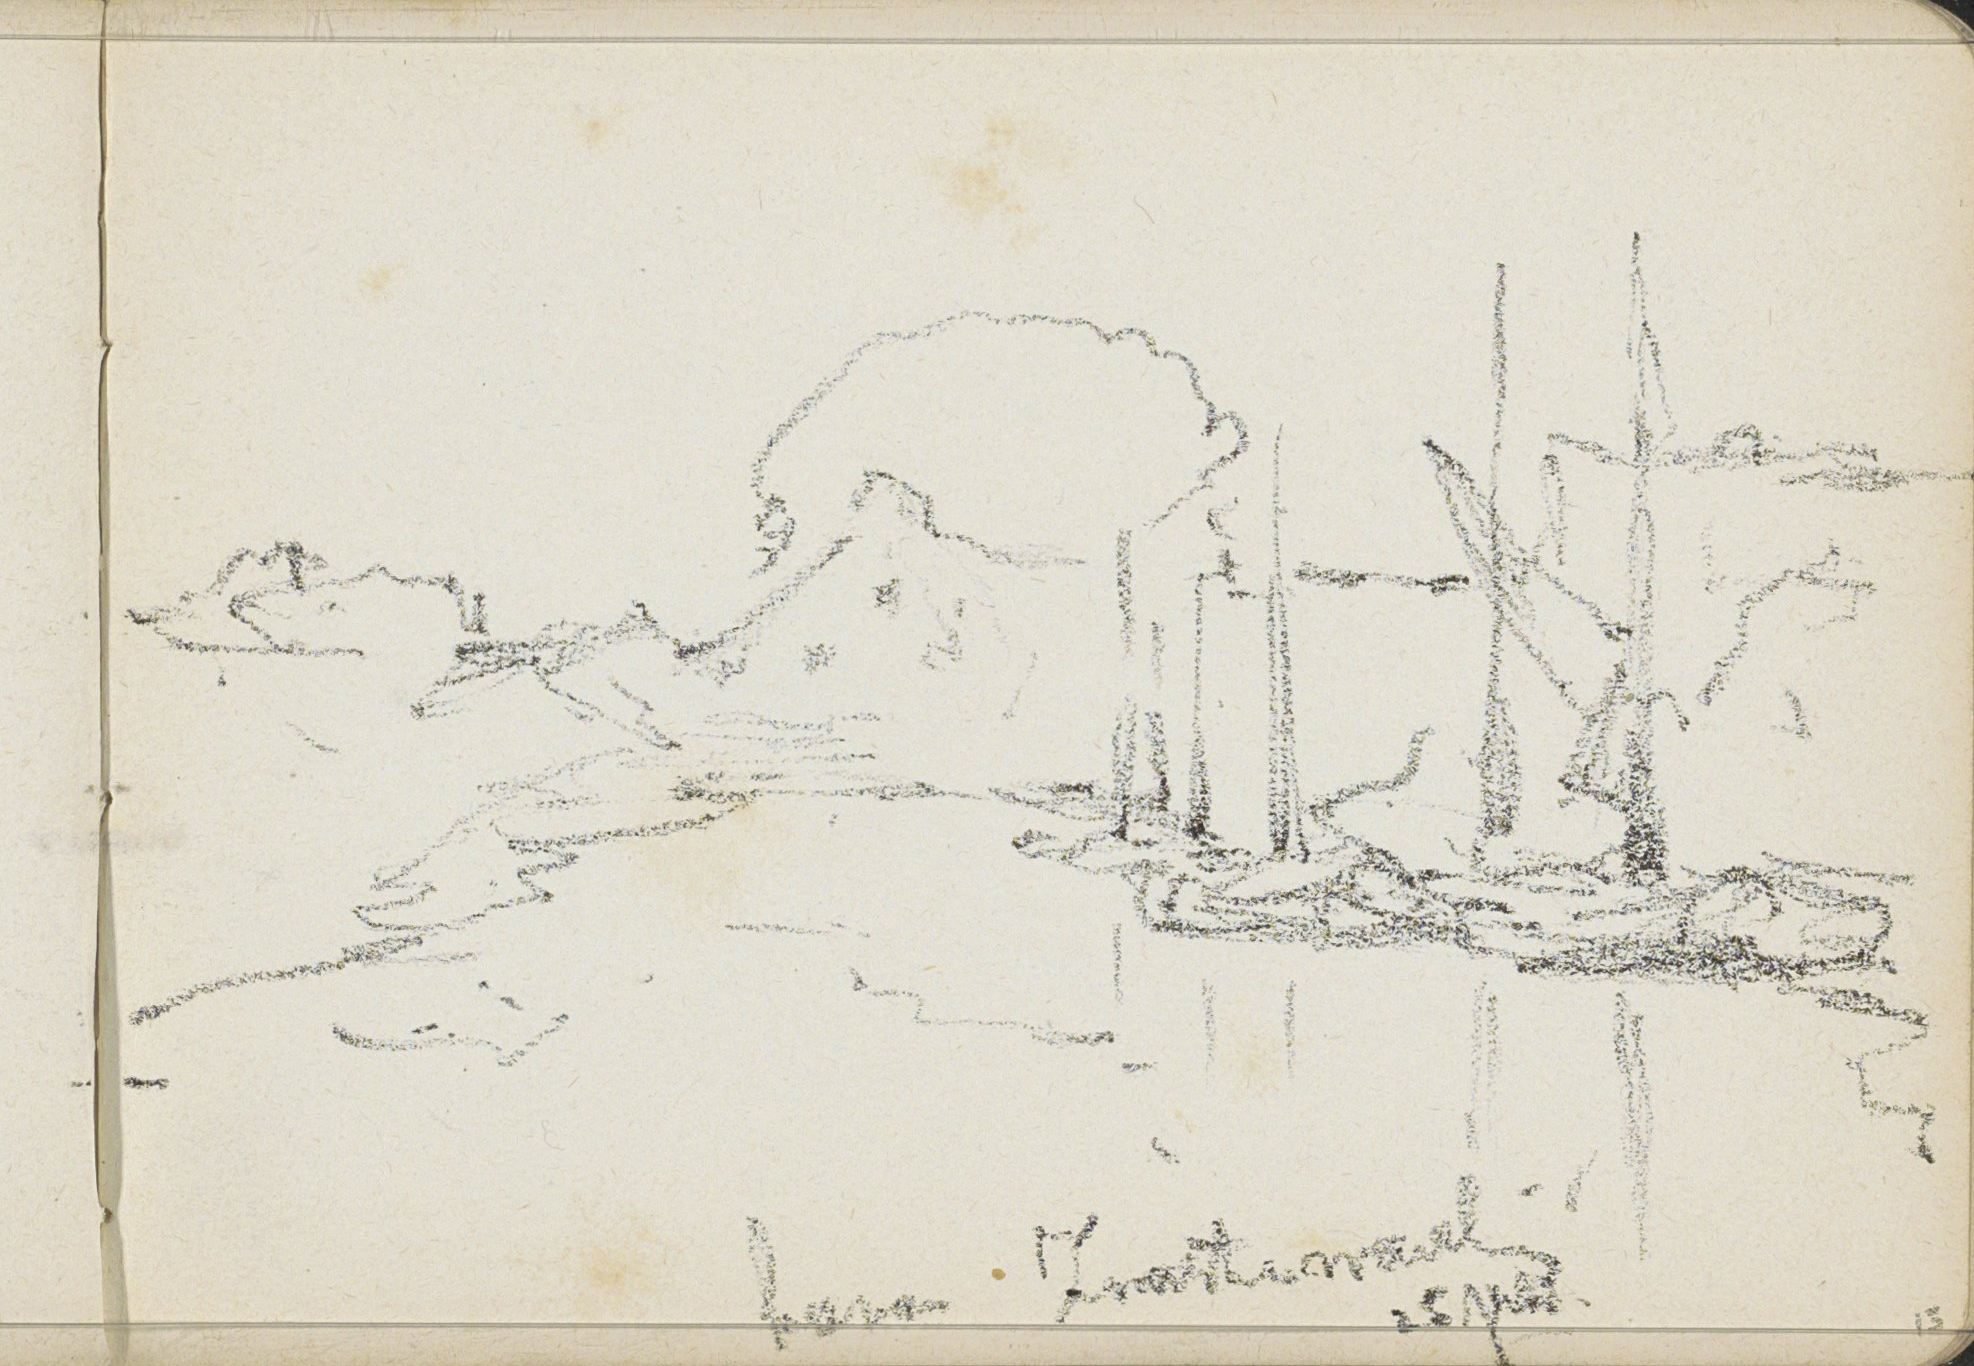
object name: sketchbook leaf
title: Zeilboten in de haven van Zwartewaal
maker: willem cornelis rip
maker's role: draughtsman, painter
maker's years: 1856-1922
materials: chalk, paper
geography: zwartewaal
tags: harbour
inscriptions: date and inscription: ‘haven Zwartewaal/ 25 juli’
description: Blad 13 recto uit een schetsboek met 42 bladen.